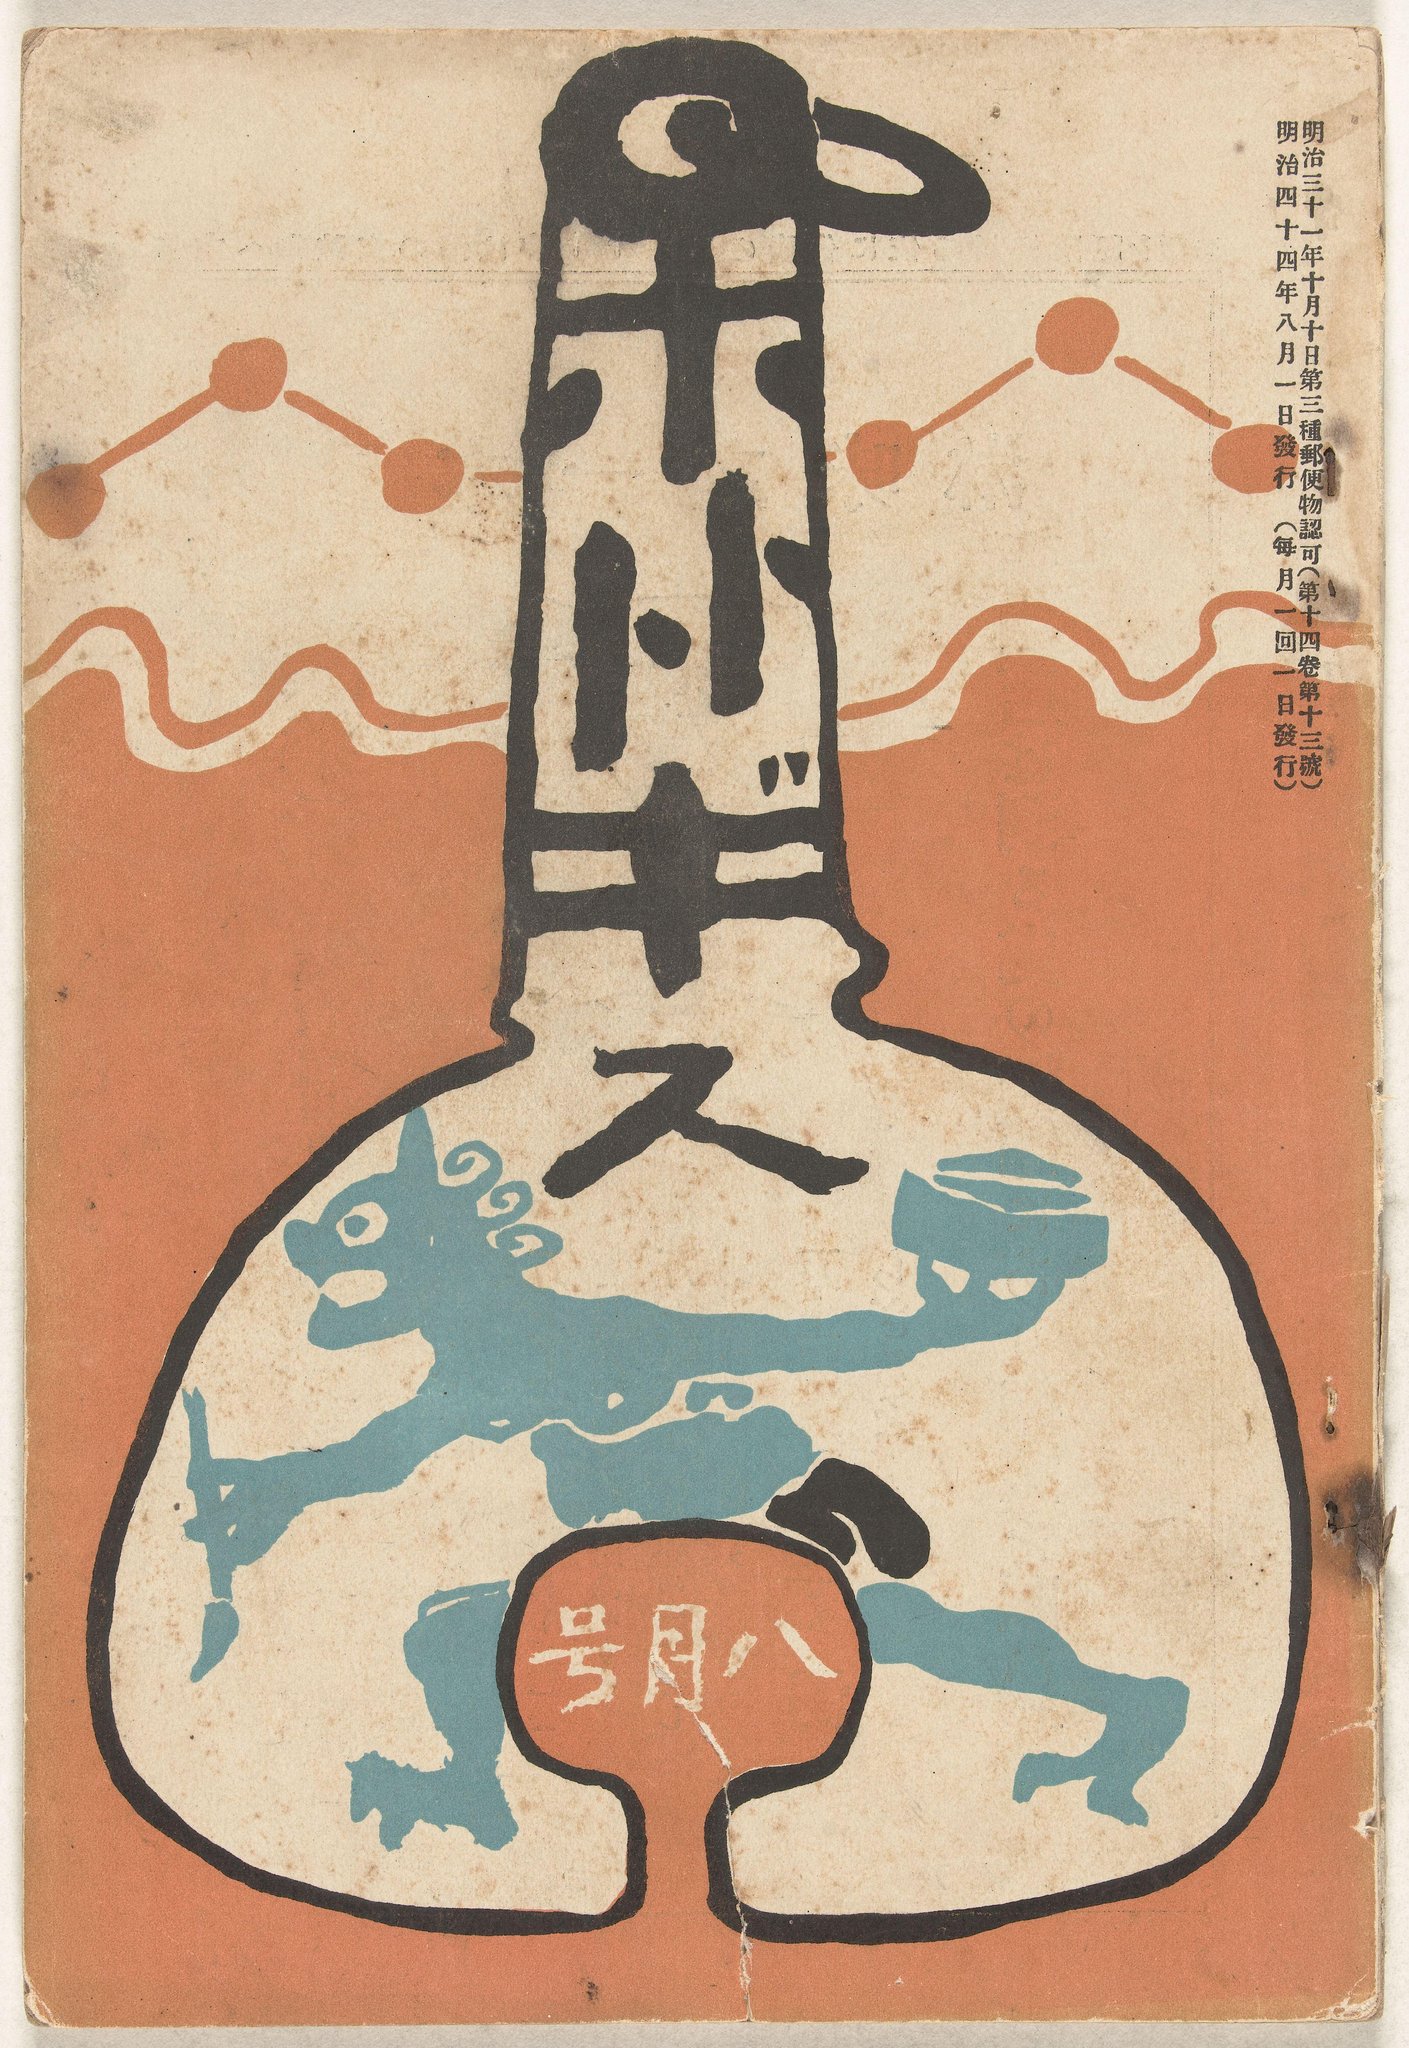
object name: magazine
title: Hototogisu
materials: paper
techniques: letterpress printing, lithograph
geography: japan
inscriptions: date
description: Nummer 13 van jaargang 14 (augustus 1911) van het literaire maandblad Hototogisu: oranjebruine kaft met sakefles waarop afbeelding van blauwe duivel met penseel; achterkant, personen op rivieroever.